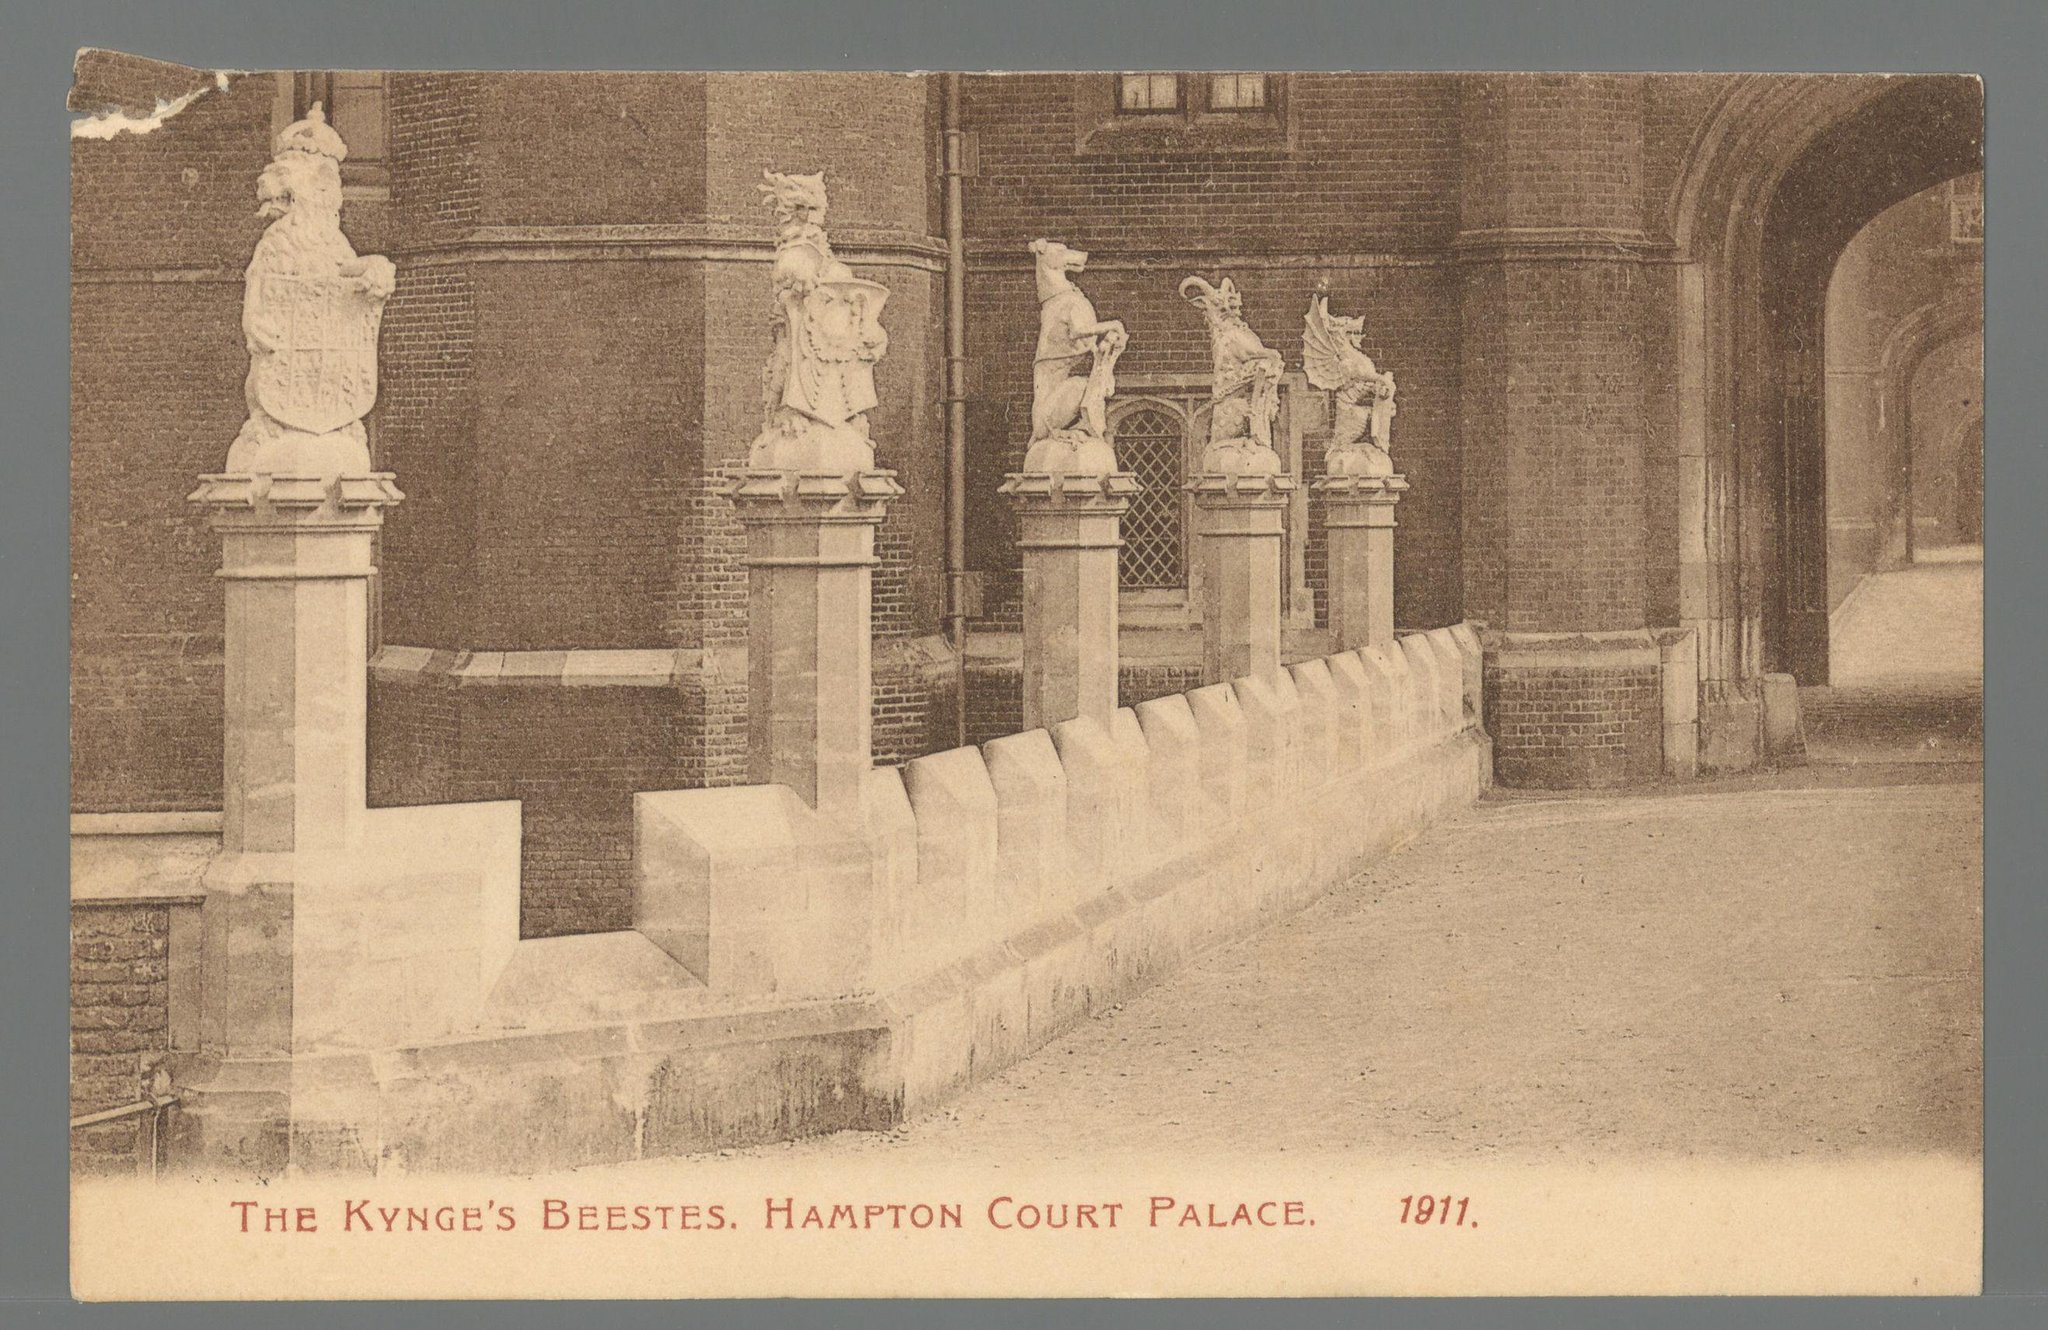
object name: ansichtkaart, prentbriefkaart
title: The Kynge's Beestes. Hampton Court Palace. 1911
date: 1911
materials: cardboard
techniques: photograph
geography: england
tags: palace, gate, entrance, monument, statue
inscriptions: date